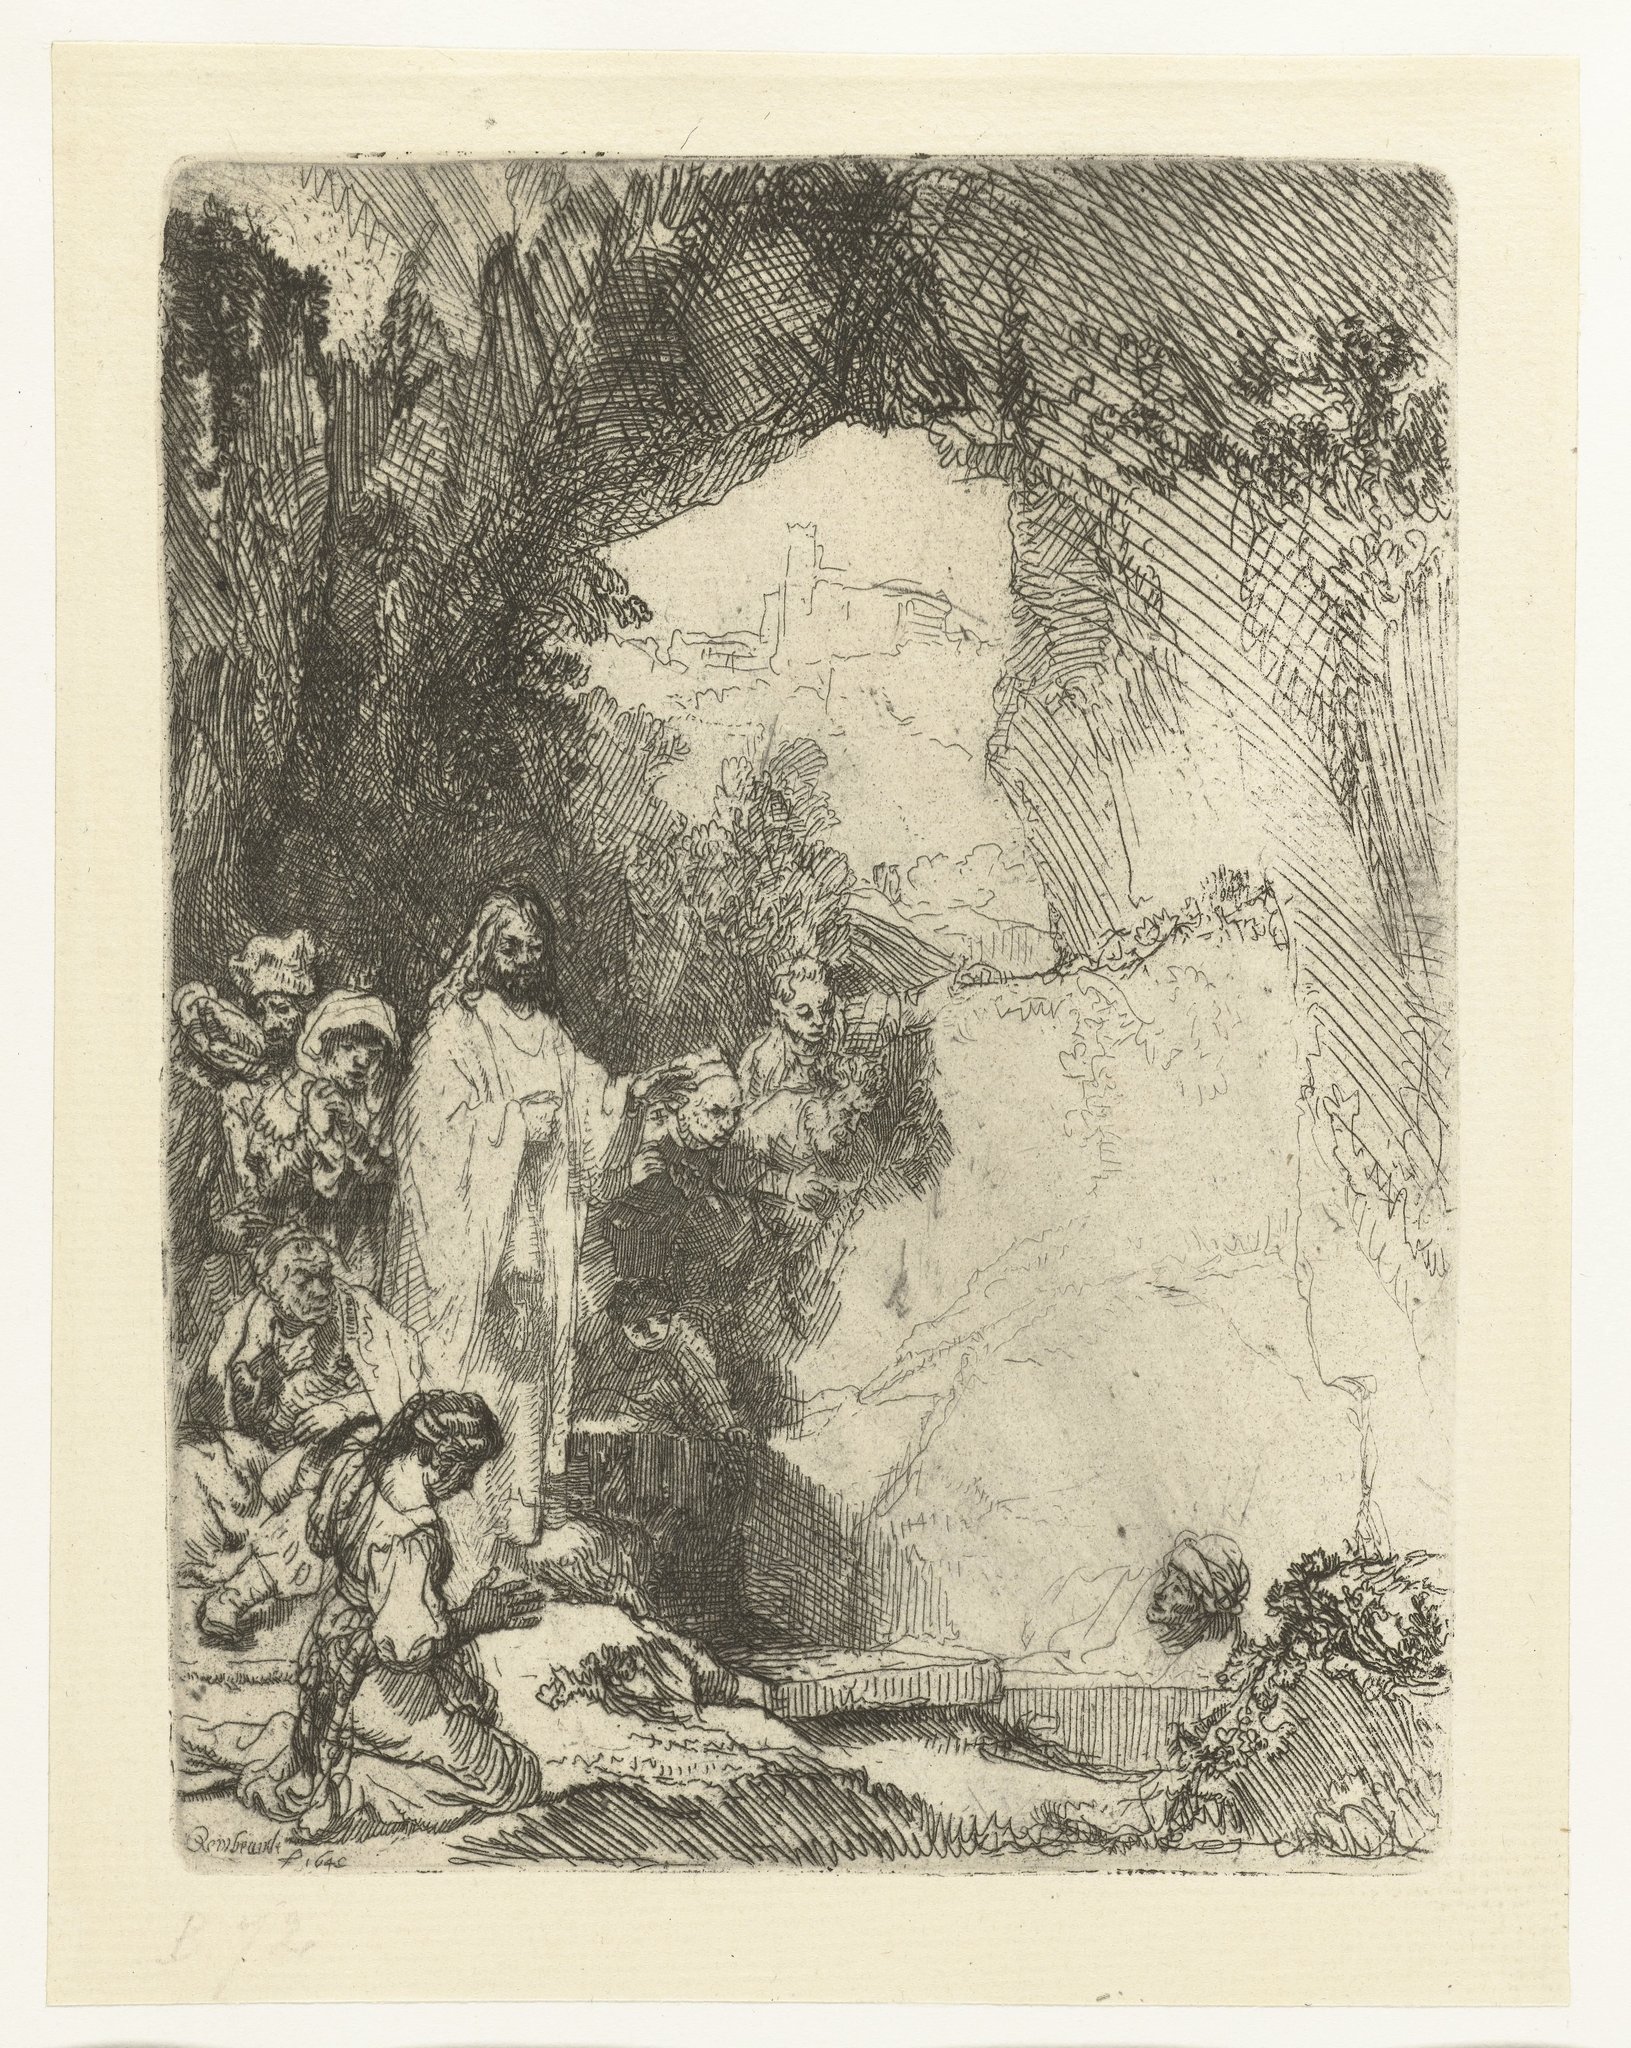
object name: print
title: The raising of Lazarus: small plate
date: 1642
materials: paper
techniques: etching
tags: the raising of lazarus ('lazarus, come out')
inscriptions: signature and date: ‘Rembrandt f 1642’, inscription: ‘Coppier’